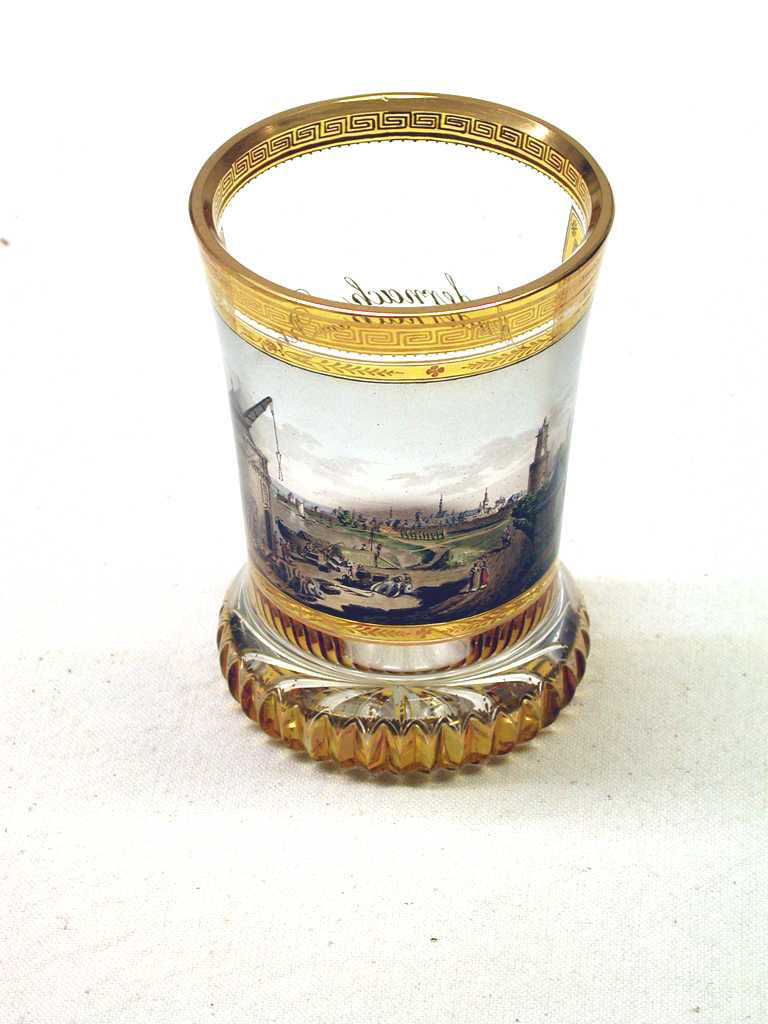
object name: beaker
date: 1815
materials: glass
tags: towns